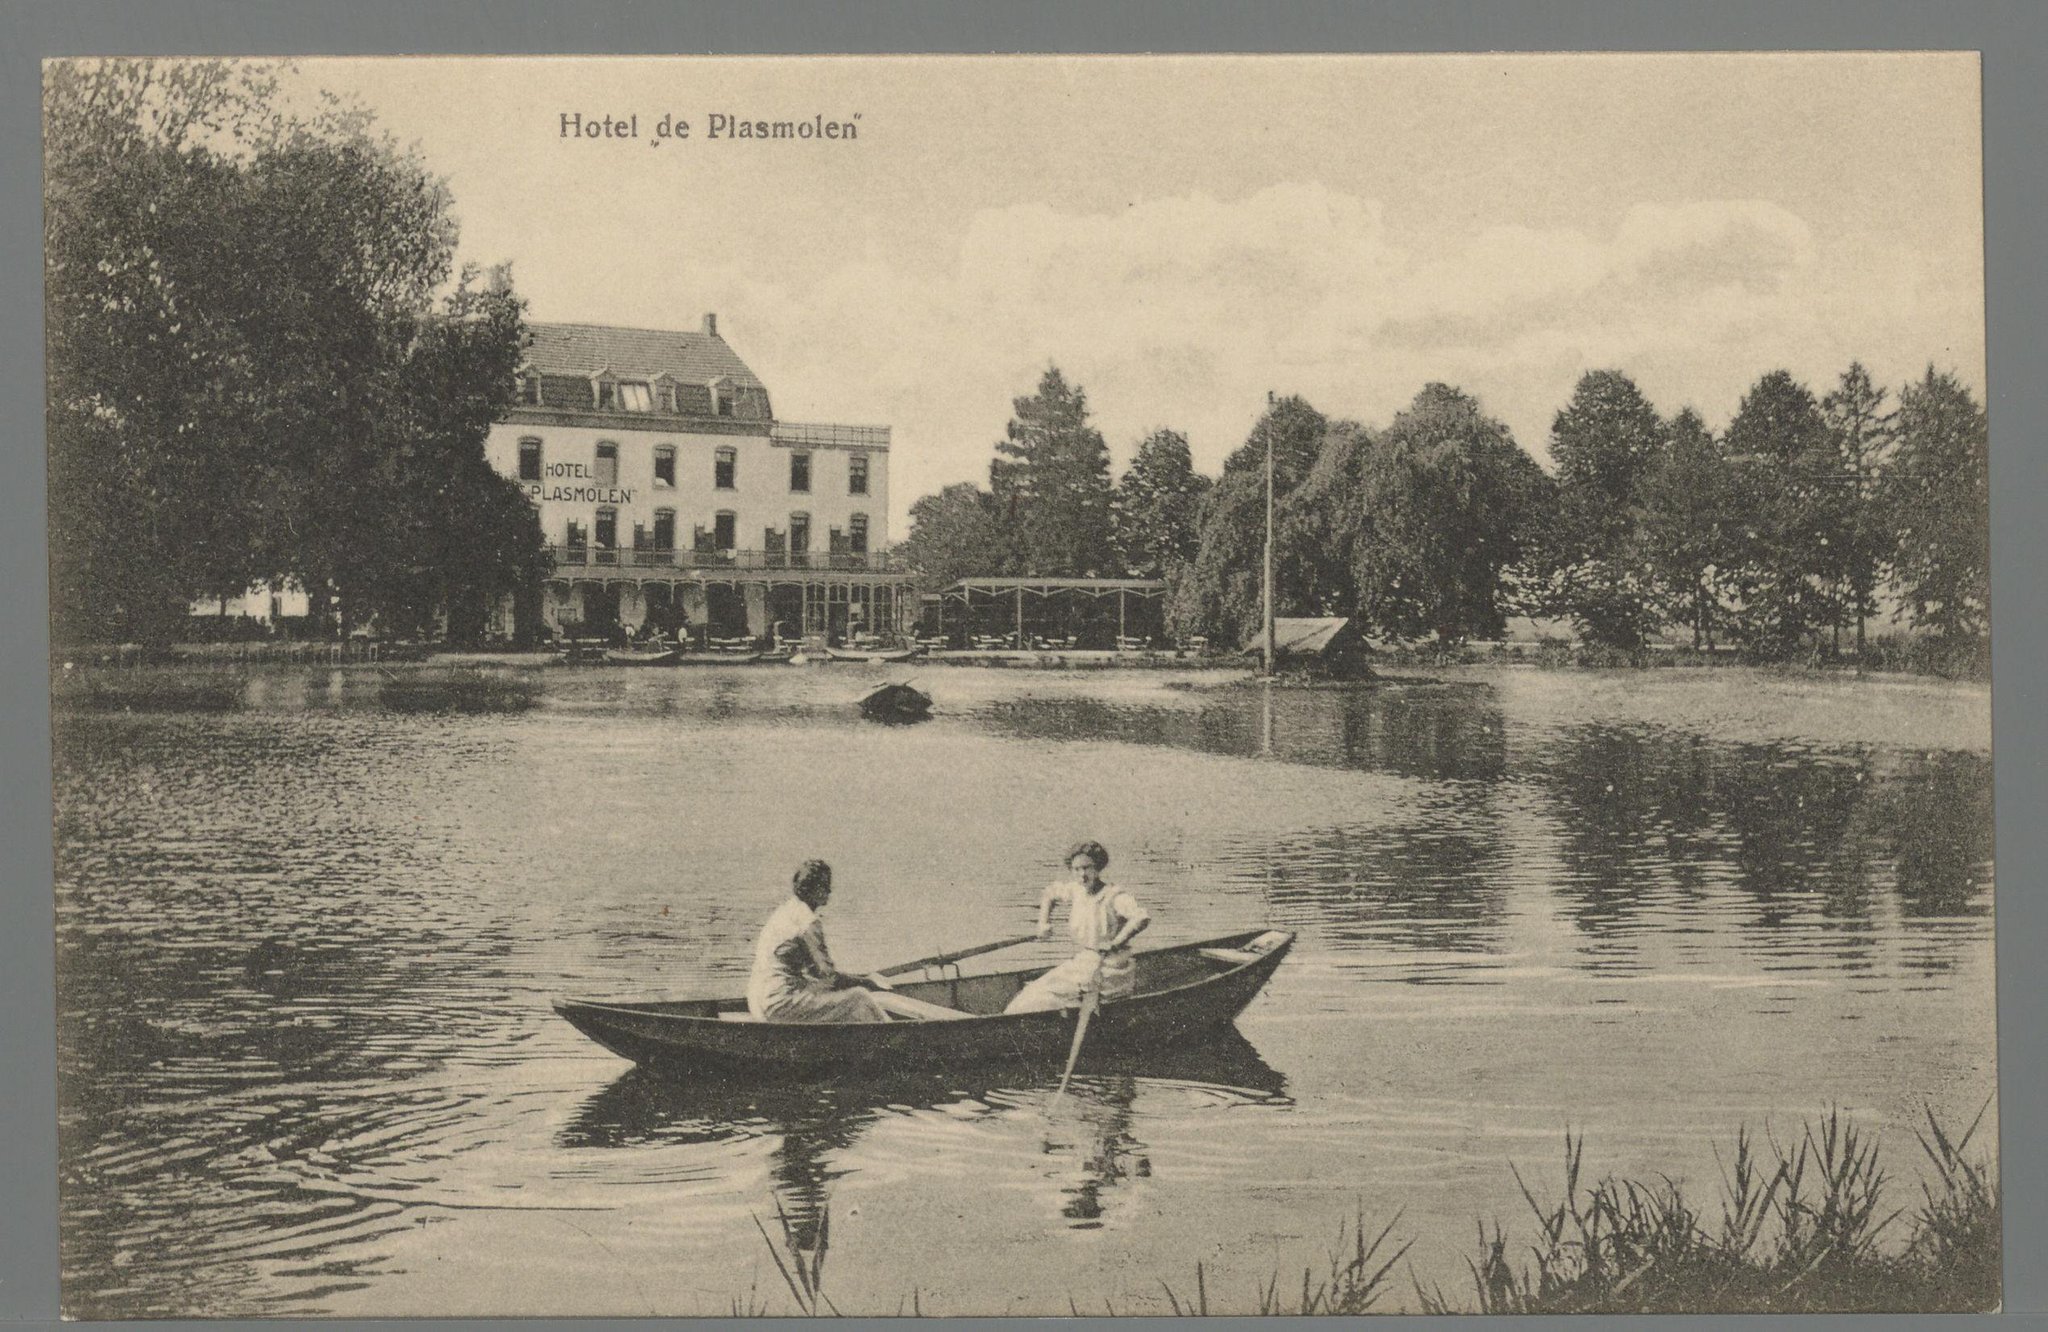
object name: ansichtkaart, prentbriefkaart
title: Hotel "de Plasmolen"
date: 1910-1929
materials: cardboard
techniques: photograph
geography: nijmegen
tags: rowing-boat, canoe, etc., pond, hotel, hostelry, inn